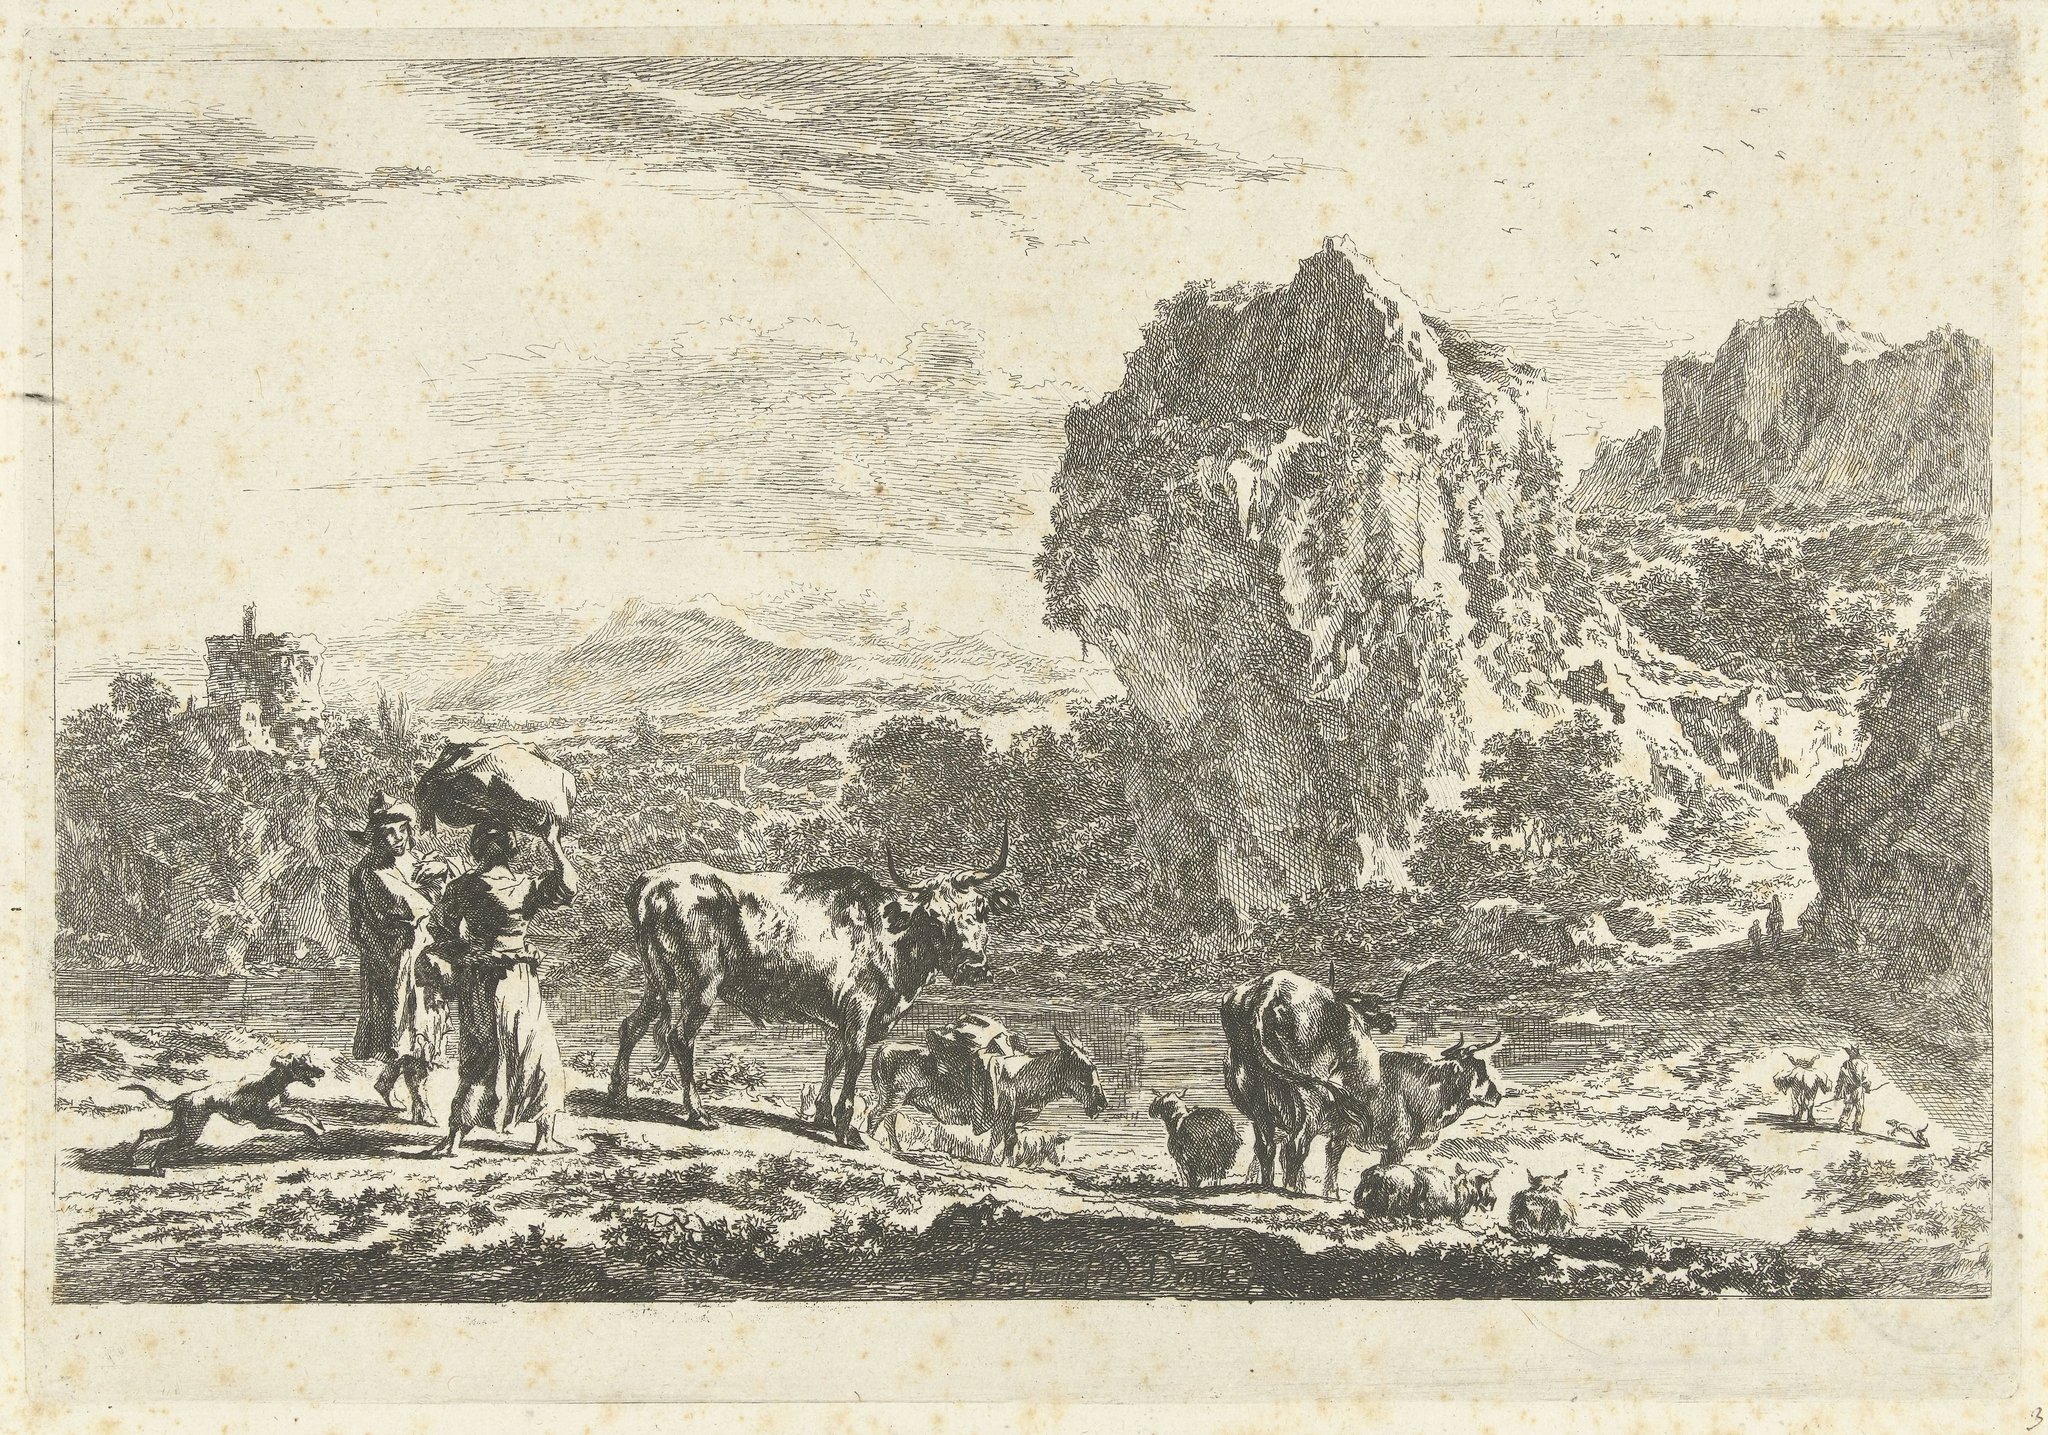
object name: print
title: Landschappen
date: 1643-1666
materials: paper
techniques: etching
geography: netherlands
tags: herding, herdsman, herdswoman, shepherd, shepherdess, cowherd, etc., rocks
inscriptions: collector's mark: Lugt 11, inscription: ‘Boek 41 N 30-33’, collector's mark: Lugt 10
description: Prent uit serie van vier landschappen naar ontwerp van Pieter Nicolaesz. Berchem.